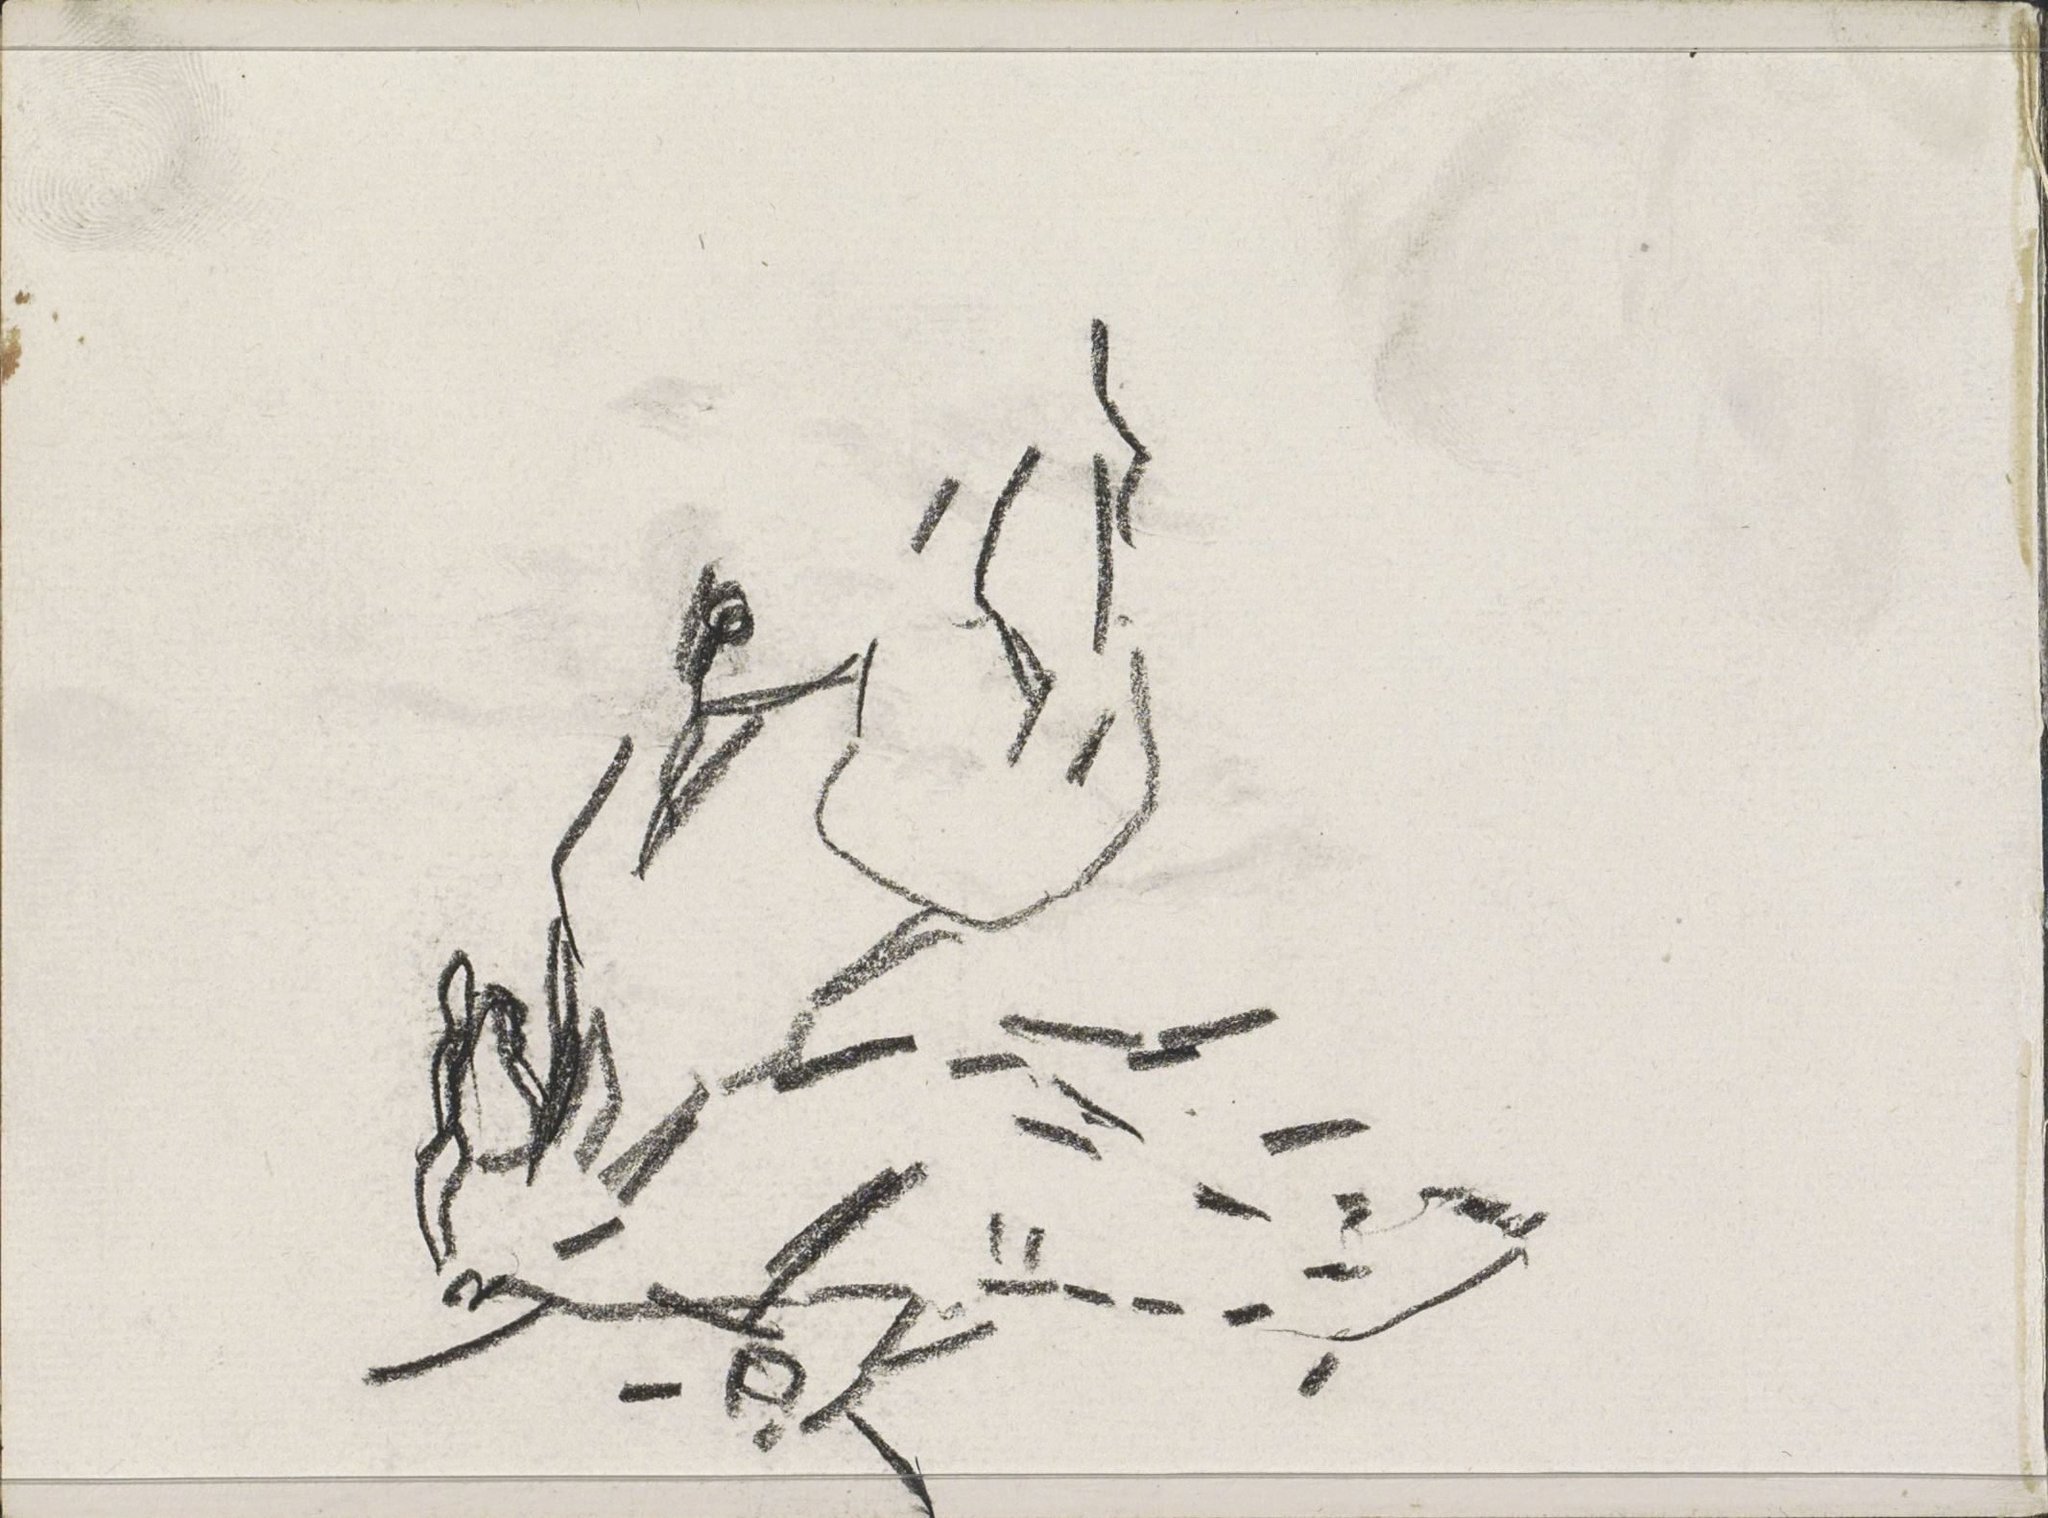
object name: sketchbook leaf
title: Paard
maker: isaac israels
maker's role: draughtsman, painter, print maker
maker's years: 1865-1934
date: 1875-1934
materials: chalk, paper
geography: the hague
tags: horse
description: Pagina 2 uit schetsboek XLI met 38 pagina's.